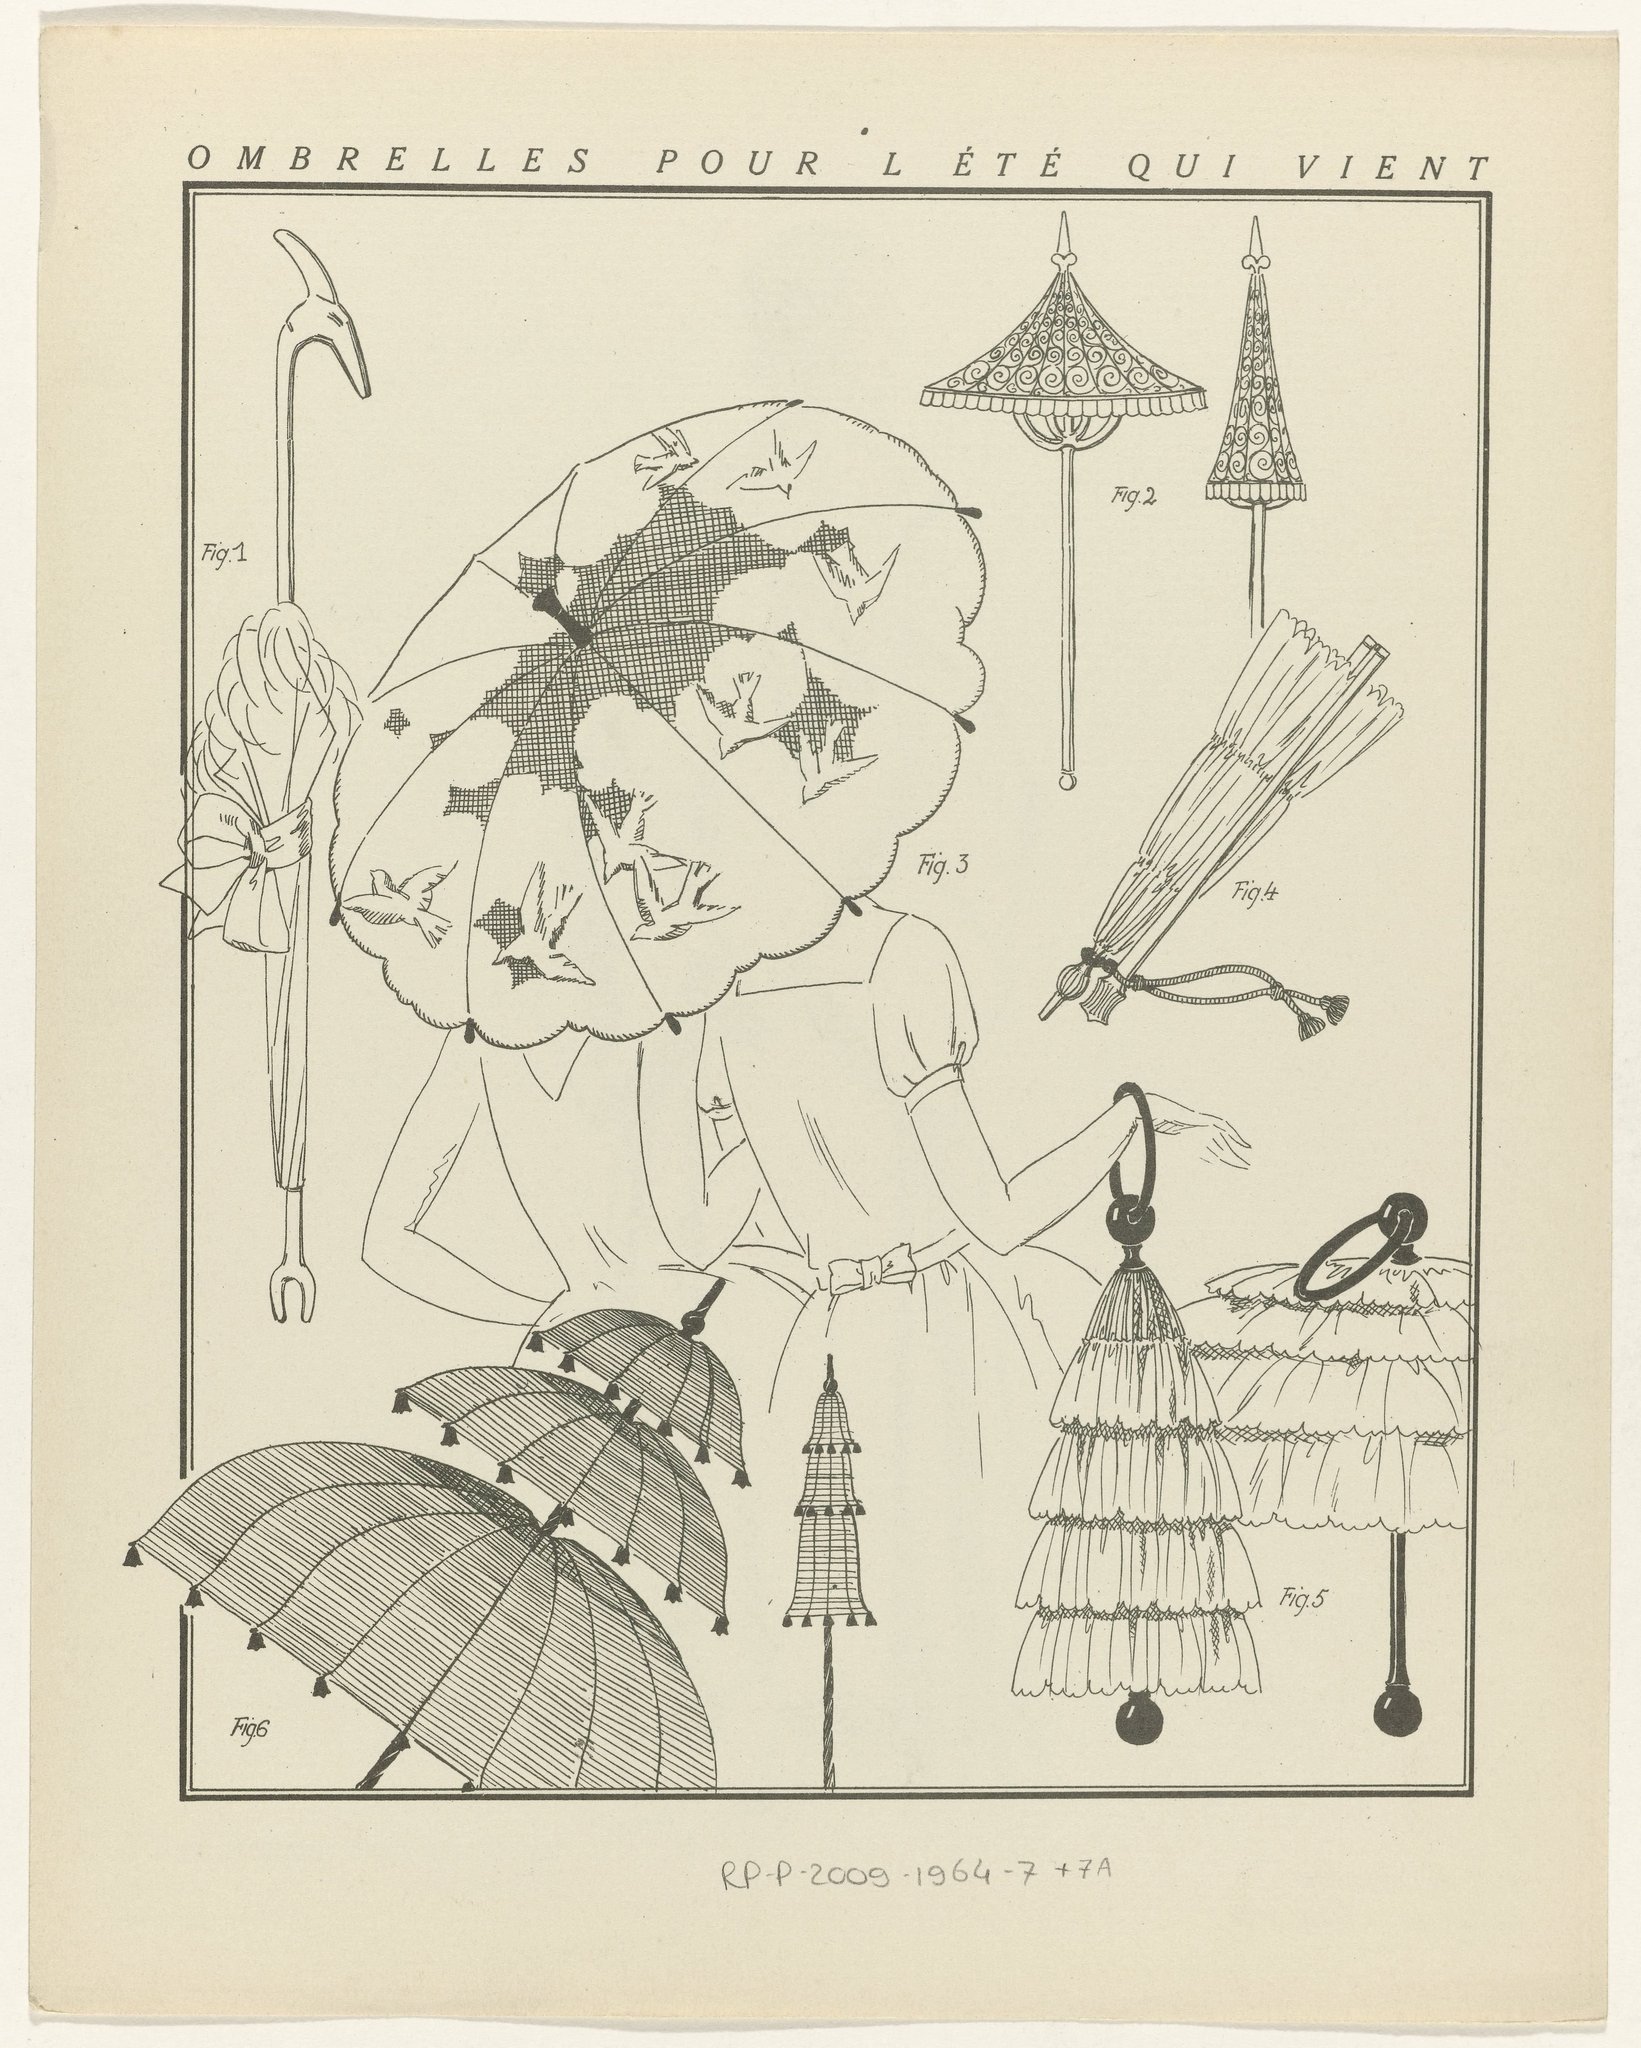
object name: fashion print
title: Accessories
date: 1922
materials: paper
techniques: letterpress printing, lithograph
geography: berlin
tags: fashion plates, parasol, sunshade (+ women's clothes)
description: Fans, parasols, opera gloves, fashionable hats, small toques garnished with feathers, wristwatches, compact bracelets, and luxuriously crafted lighters: there was a dazzling variety of accessories in the 1920s. Small bags could be suspended from a belt, or a glove. Walking sticks and the shafts of umbrellas and parasols were often embellished with carving clearly inspired by African and Indian art. And Russian influence was evident when it came to combs made of mother-of-pearl and ivory.